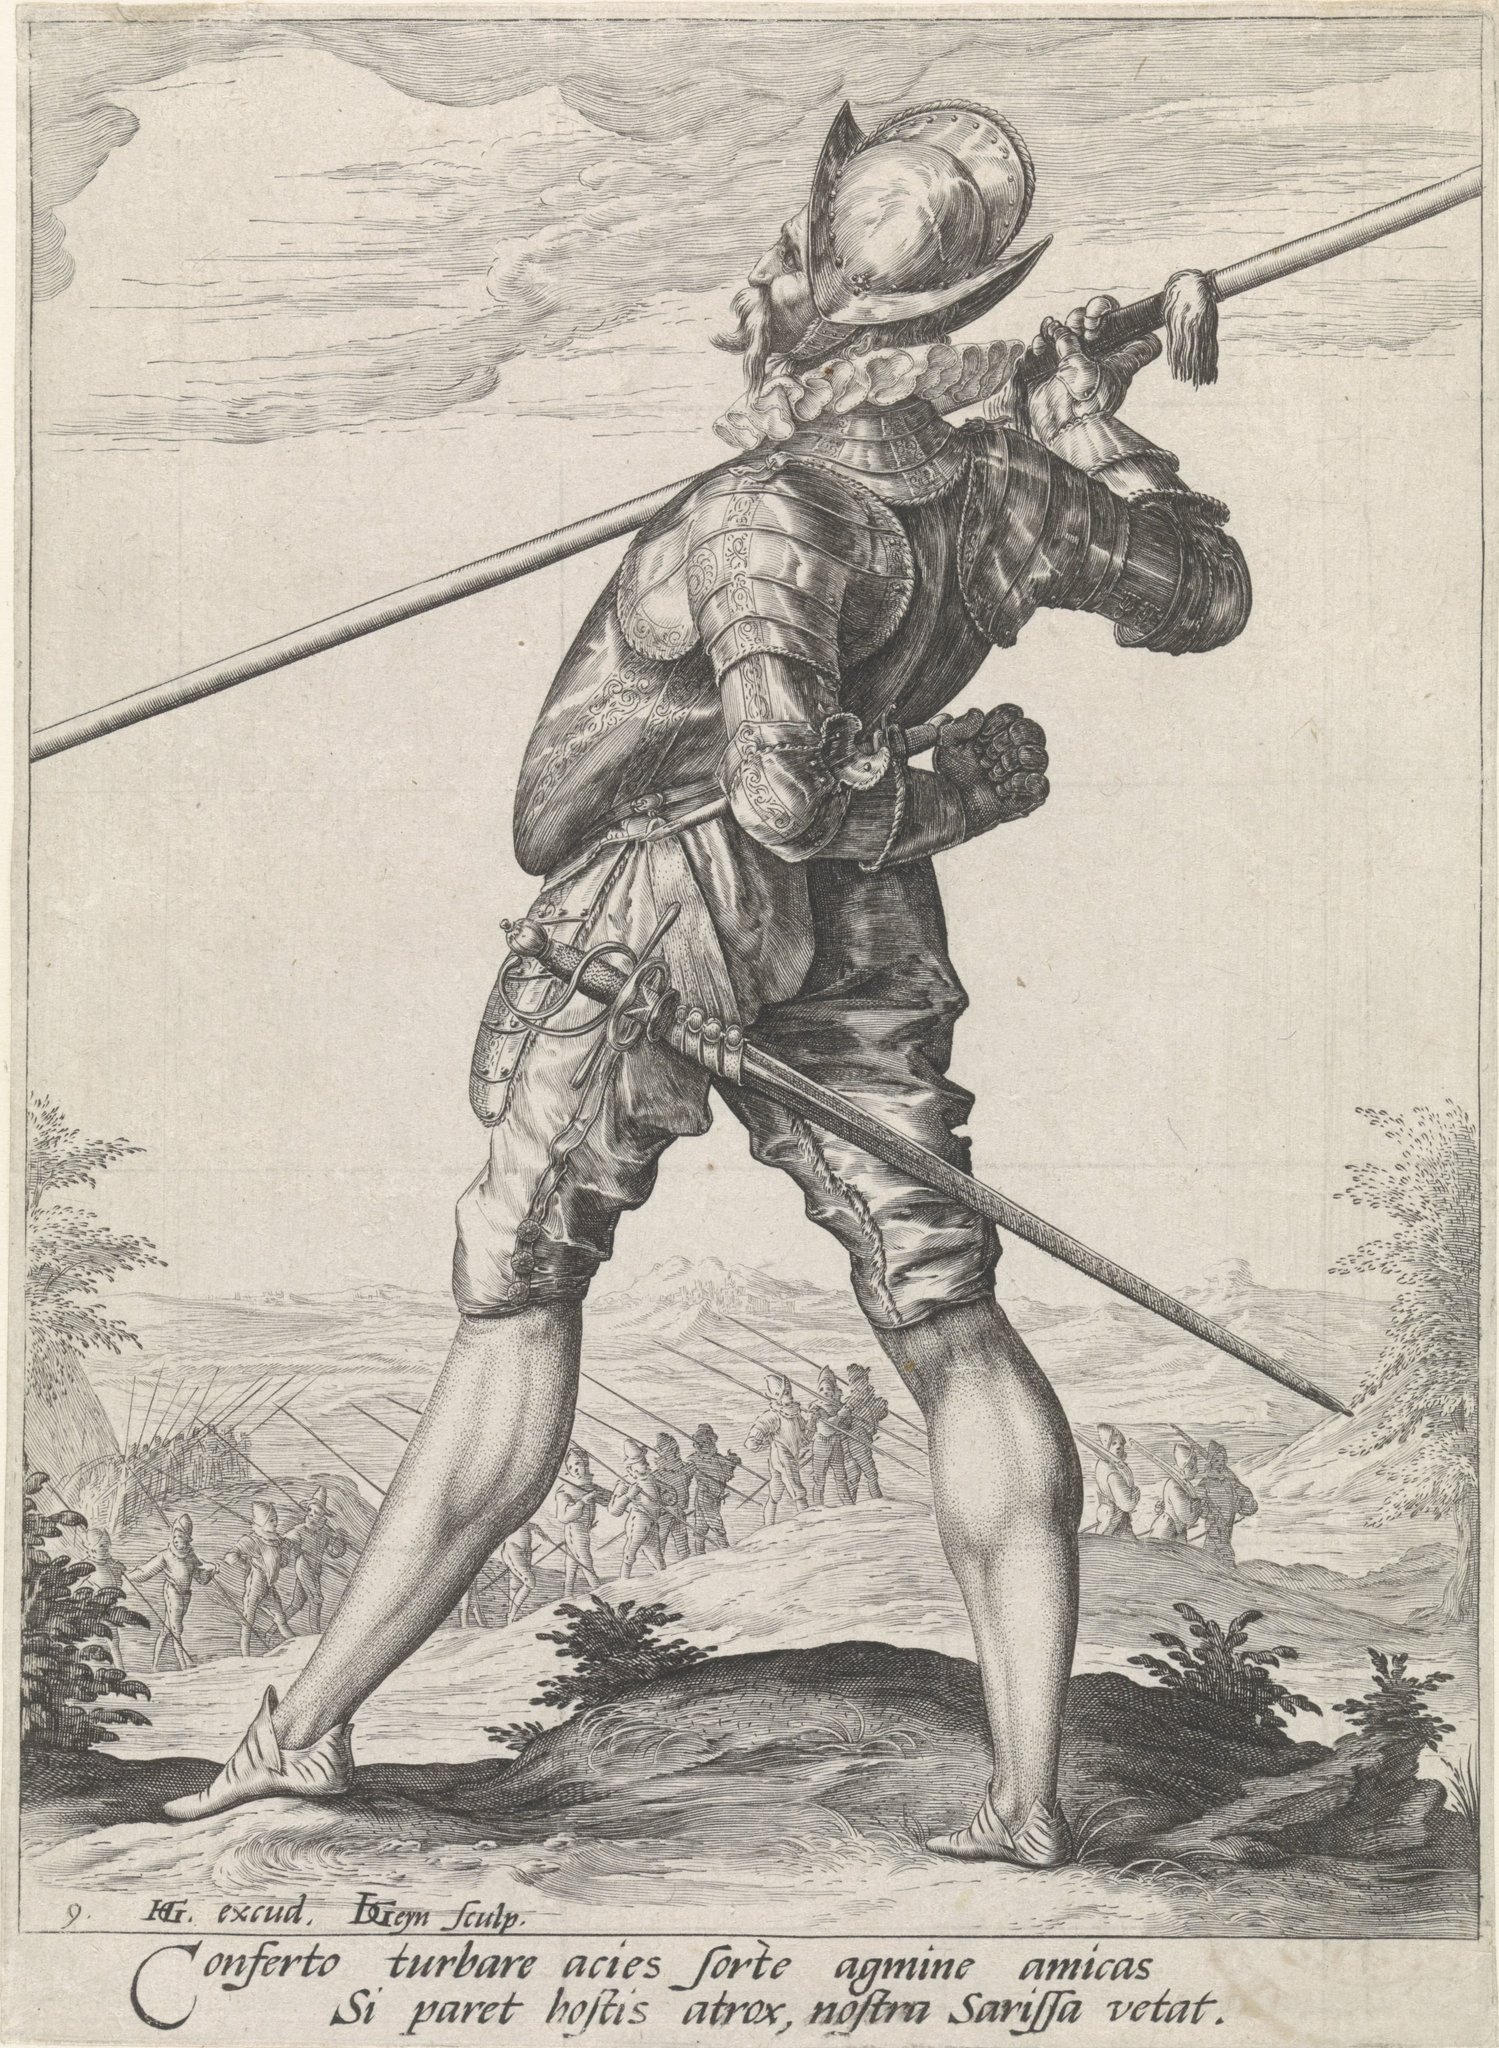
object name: print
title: Piekenier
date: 1587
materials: paper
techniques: engraving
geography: haarlem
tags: troop movements, transportation, helved weapons, polearms (for striking, hacking, thrusting): pike, private soldier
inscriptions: collector's mark: Lugt 240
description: Een man in militaire uitdossing (een piekenier), ten voeten uit, op de linkerzijde gezien, een zwaard aan zijn gordel, een stokwapen (piek of lans) in zijn rechterhand. Op de achtergrond een heuvelachtig landschap waarin een troep soldaten marcheert. Onder de voorstelling twee regels tekst in Latijn. Deze prent is onderdeel van een serie van 12 genummerde prenten van militairen, ten voeten uit weergegeven tegen een landschappelijke achtergrond waarin krijgshandelingen verricht worden, en met een tweeregelig Latijns onderschrift.